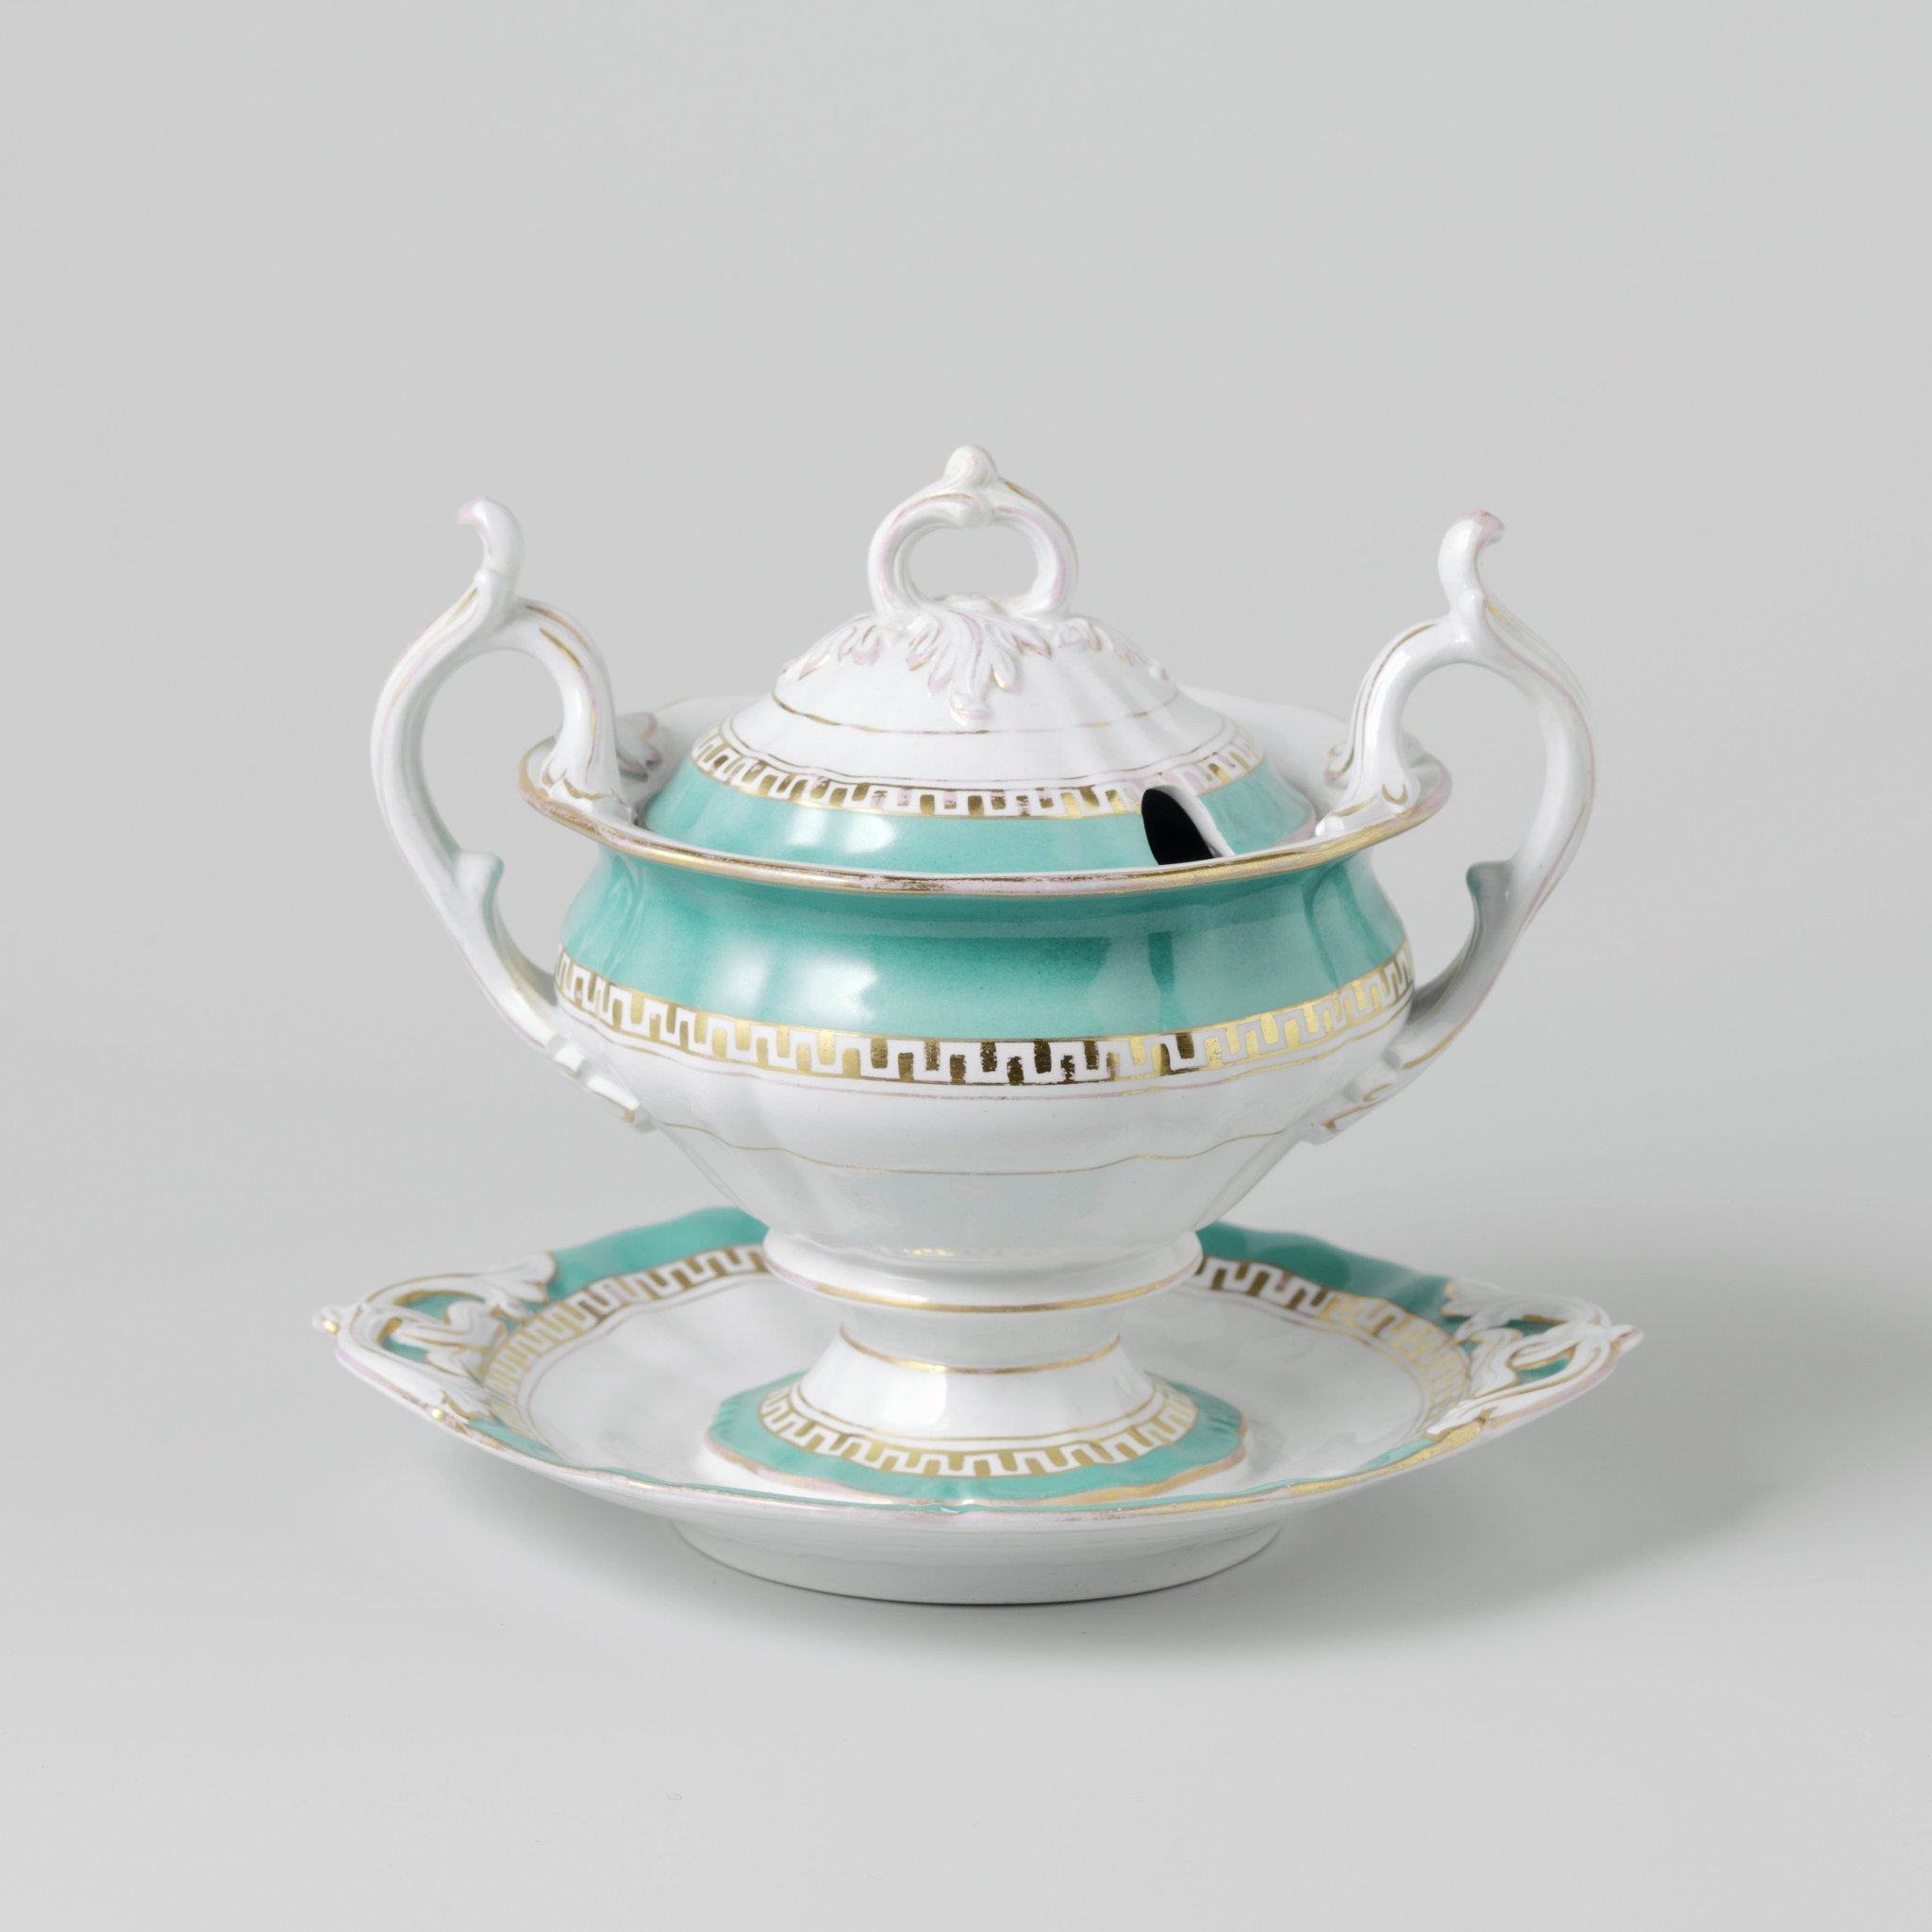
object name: tureen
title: Terrine met deksel, op vaste onderschotel, met groene rand en gouden Griekse band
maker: petrus regout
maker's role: plateelbakker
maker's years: 1801-1879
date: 1865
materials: earthenware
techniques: transfer decoration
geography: maastricht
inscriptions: check stamp: ‘20’, mark: ‘P. REGOUT HOLLAND MAASTRICHT’, check stamp: ‘P. REGOUT // MAASTRICHT // 2X 7’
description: Terrine van aardewerk, met deksel en op vaste onderschotel, rond, geschulpt, met groene rand en gouden Griekse band.